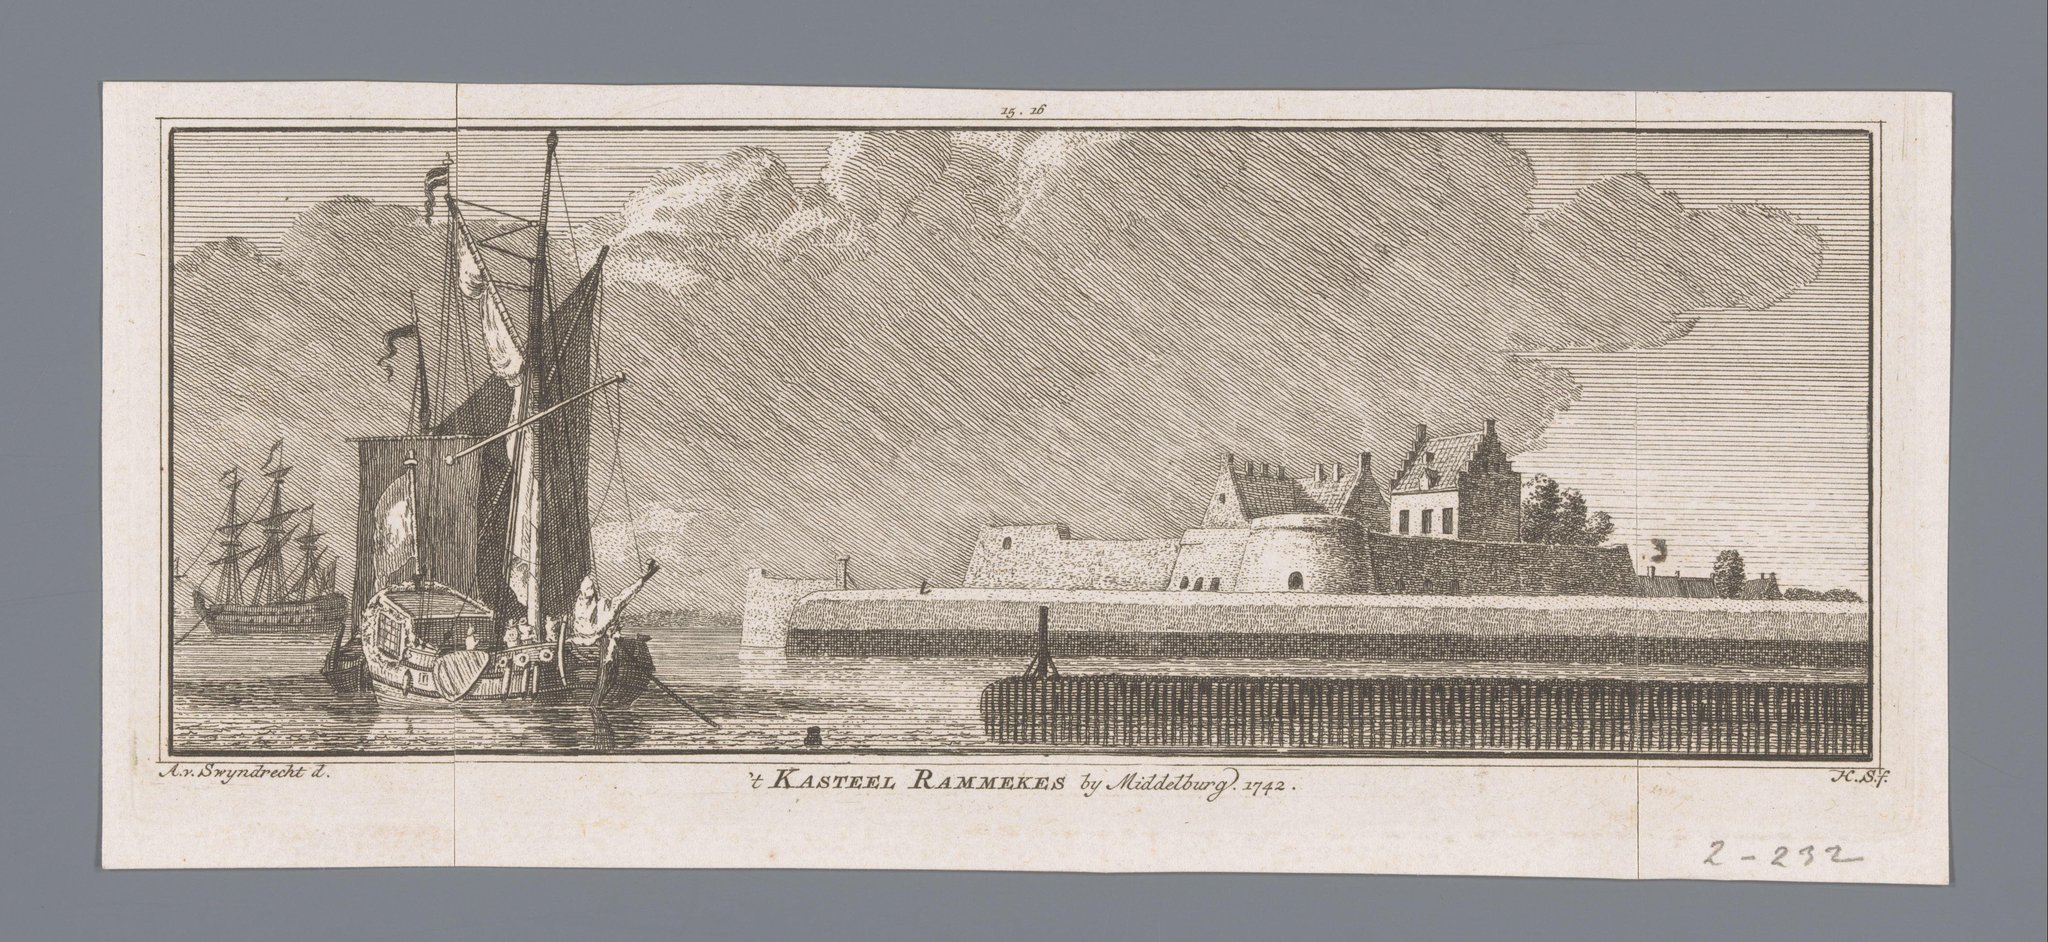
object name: print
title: Het verheerlykt Nederland of Kabinet van Hedendaagsche Gezigten (...)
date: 1754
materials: paper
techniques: etching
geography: amsterdam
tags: fortress, sailing-ship, sailing-boat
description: Prent uit: Het verheerlykt Nederland of Kabinet van Hedendaagsche Gezigten (...). Amsterdam: Isaak Tirion, 1754, dl. 5.